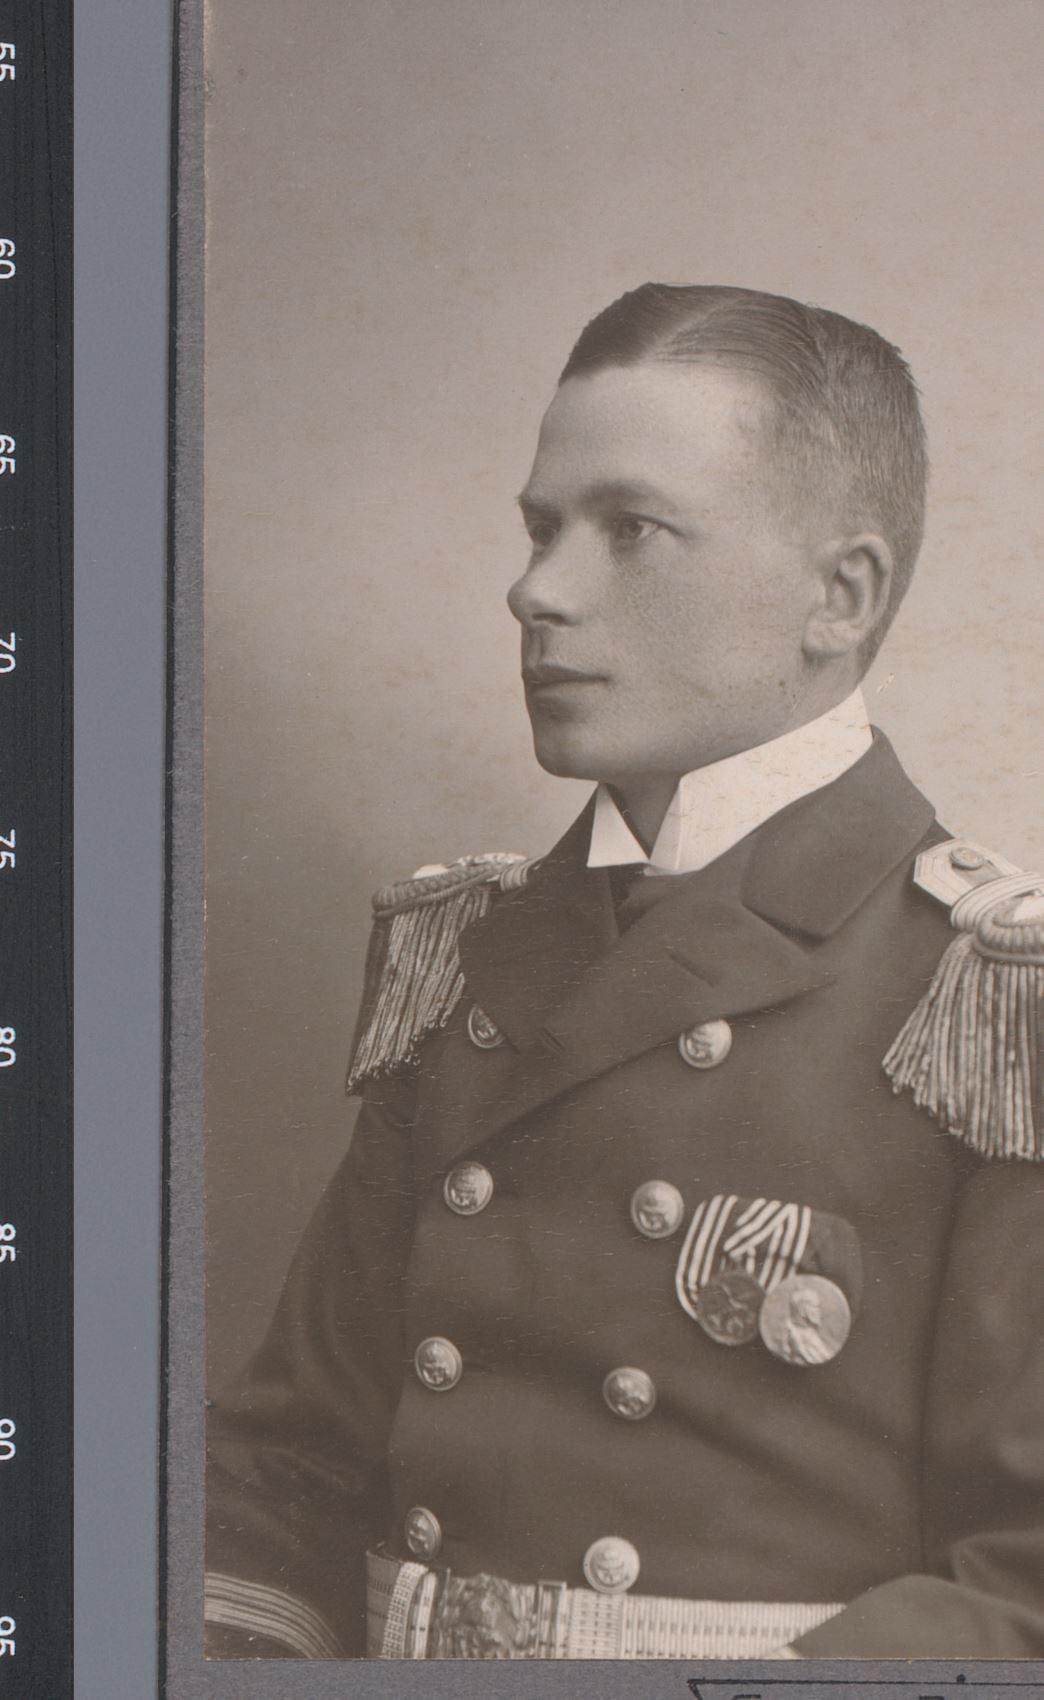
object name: photograph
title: Portret van Robert Fischer in uniform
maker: georg billstrom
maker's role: fotograaf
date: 1905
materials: paper, cardboard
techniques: gelatin silver print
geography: kiel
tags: adult man, historical persons, (military) uniforms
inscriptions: inscription: ‘Fur Erinnerung/ Robert Fischer/ Kiel/ S. M. S. Züringen/ Vugtuber 1906 [?]’, stamp: ‘29.8-.05.’, address: ‘KIEL/ Holstenstr. 43.’